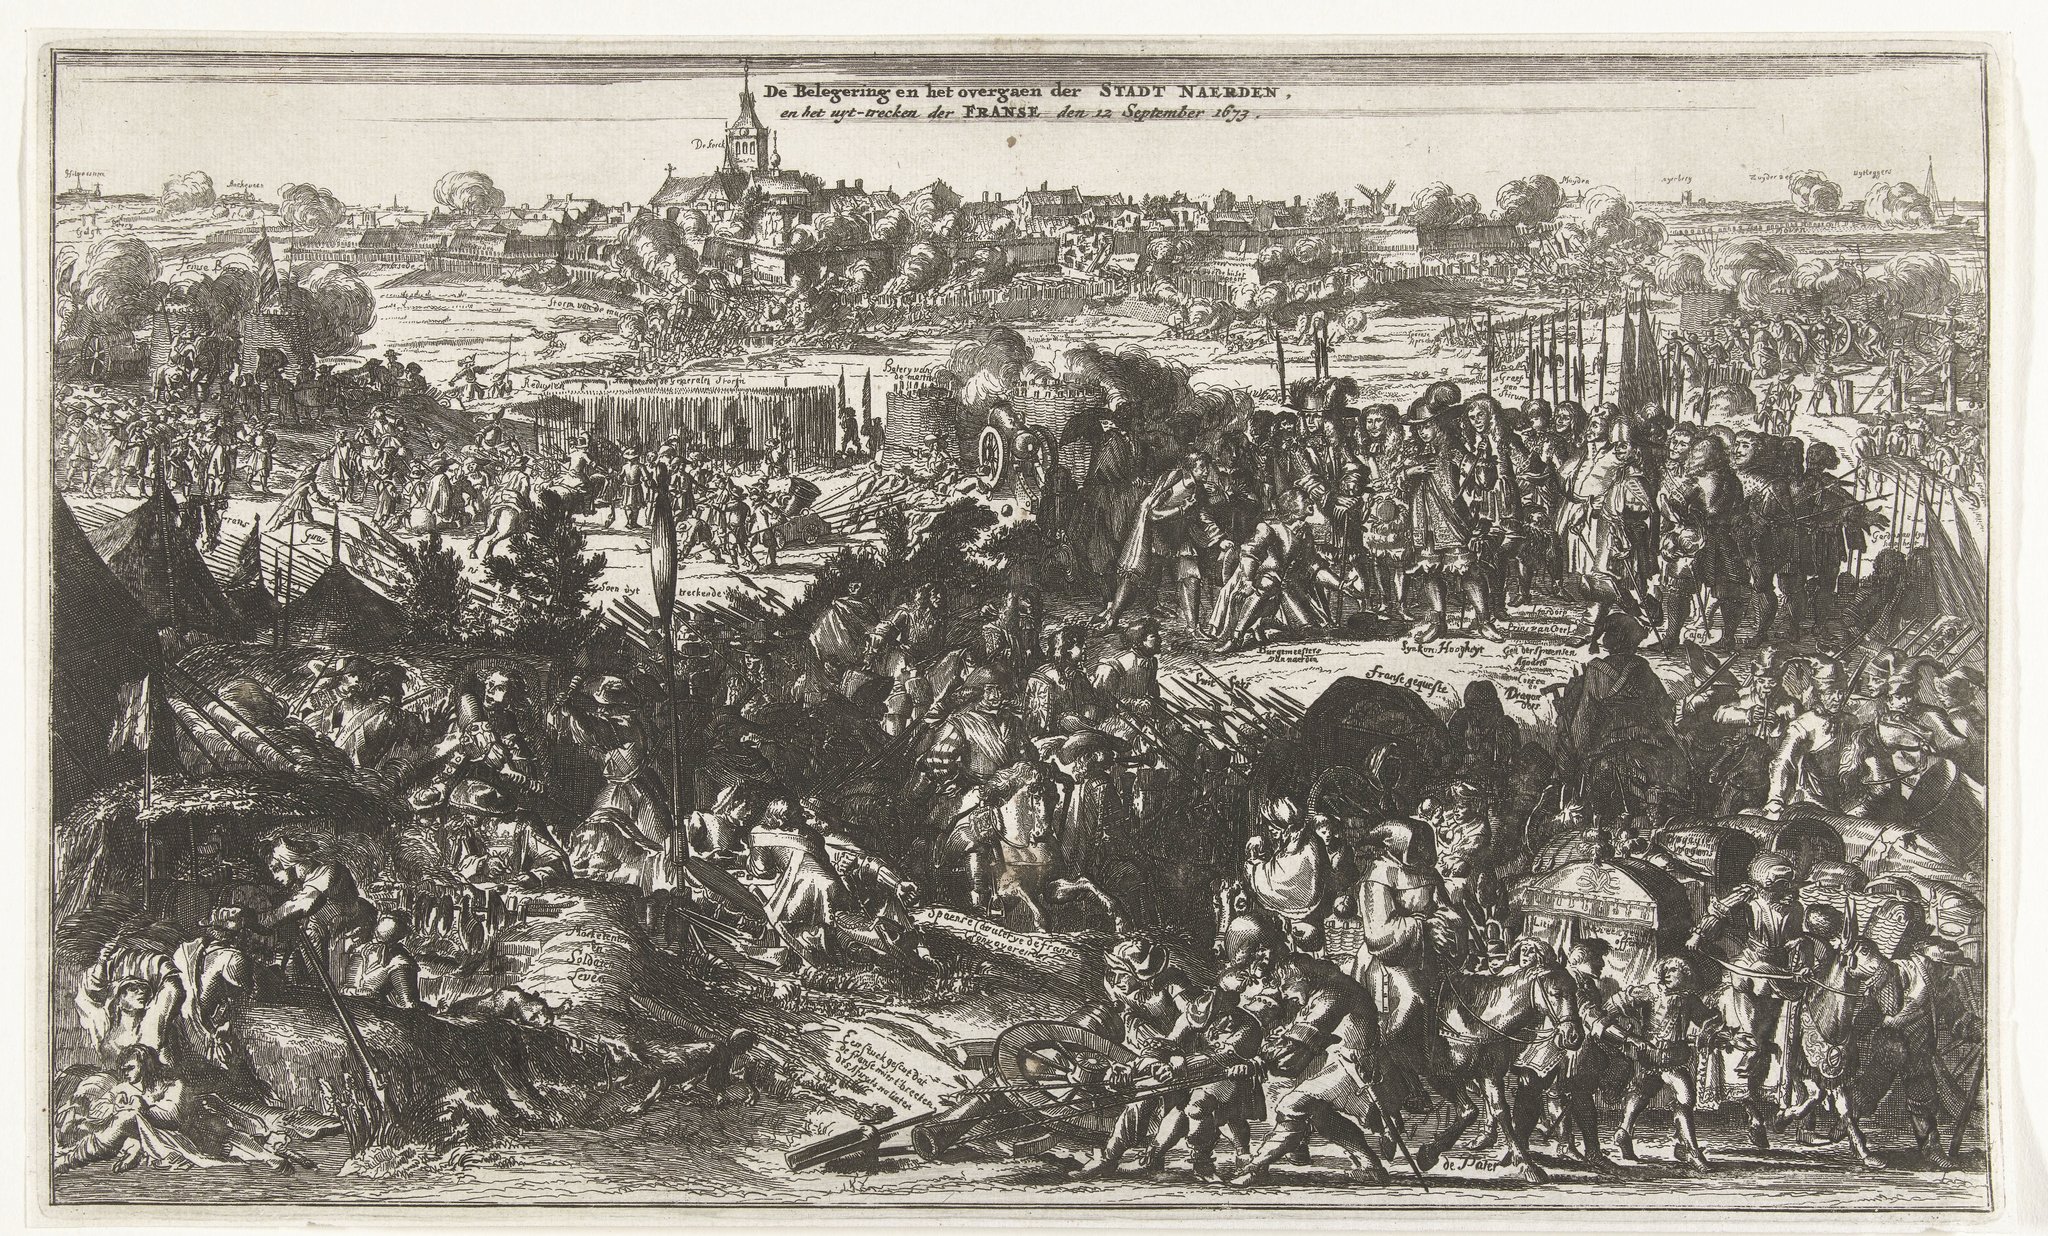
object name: history print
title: Belegering en verovering van Naarden door de prins van Oranje, 1673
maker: Anonymous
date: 1673-1675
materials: paper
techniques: etching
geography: northern netherlands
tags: william iii (prince of orange and king of england, scotland, and ireland), siege, position war, capture of city (after the siege)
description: Kopie naar de prent van Romeyn de Hooghe (FMH 2495).. Gebruikt als illustratie in: Lambert van den Bosch, Tooneel des oorlogs, opgerecht in de Vereenigde Nederlanden door de wapenen van de koningen van Vrankryk en Engeland, Keulsche en Munstersche bisschoppen : tegen de Staten der Vereenigde Nederlanden, en hare geallieerden, J. van Meurs en J. van Someren, Amsterdam 1675, 4 delen.